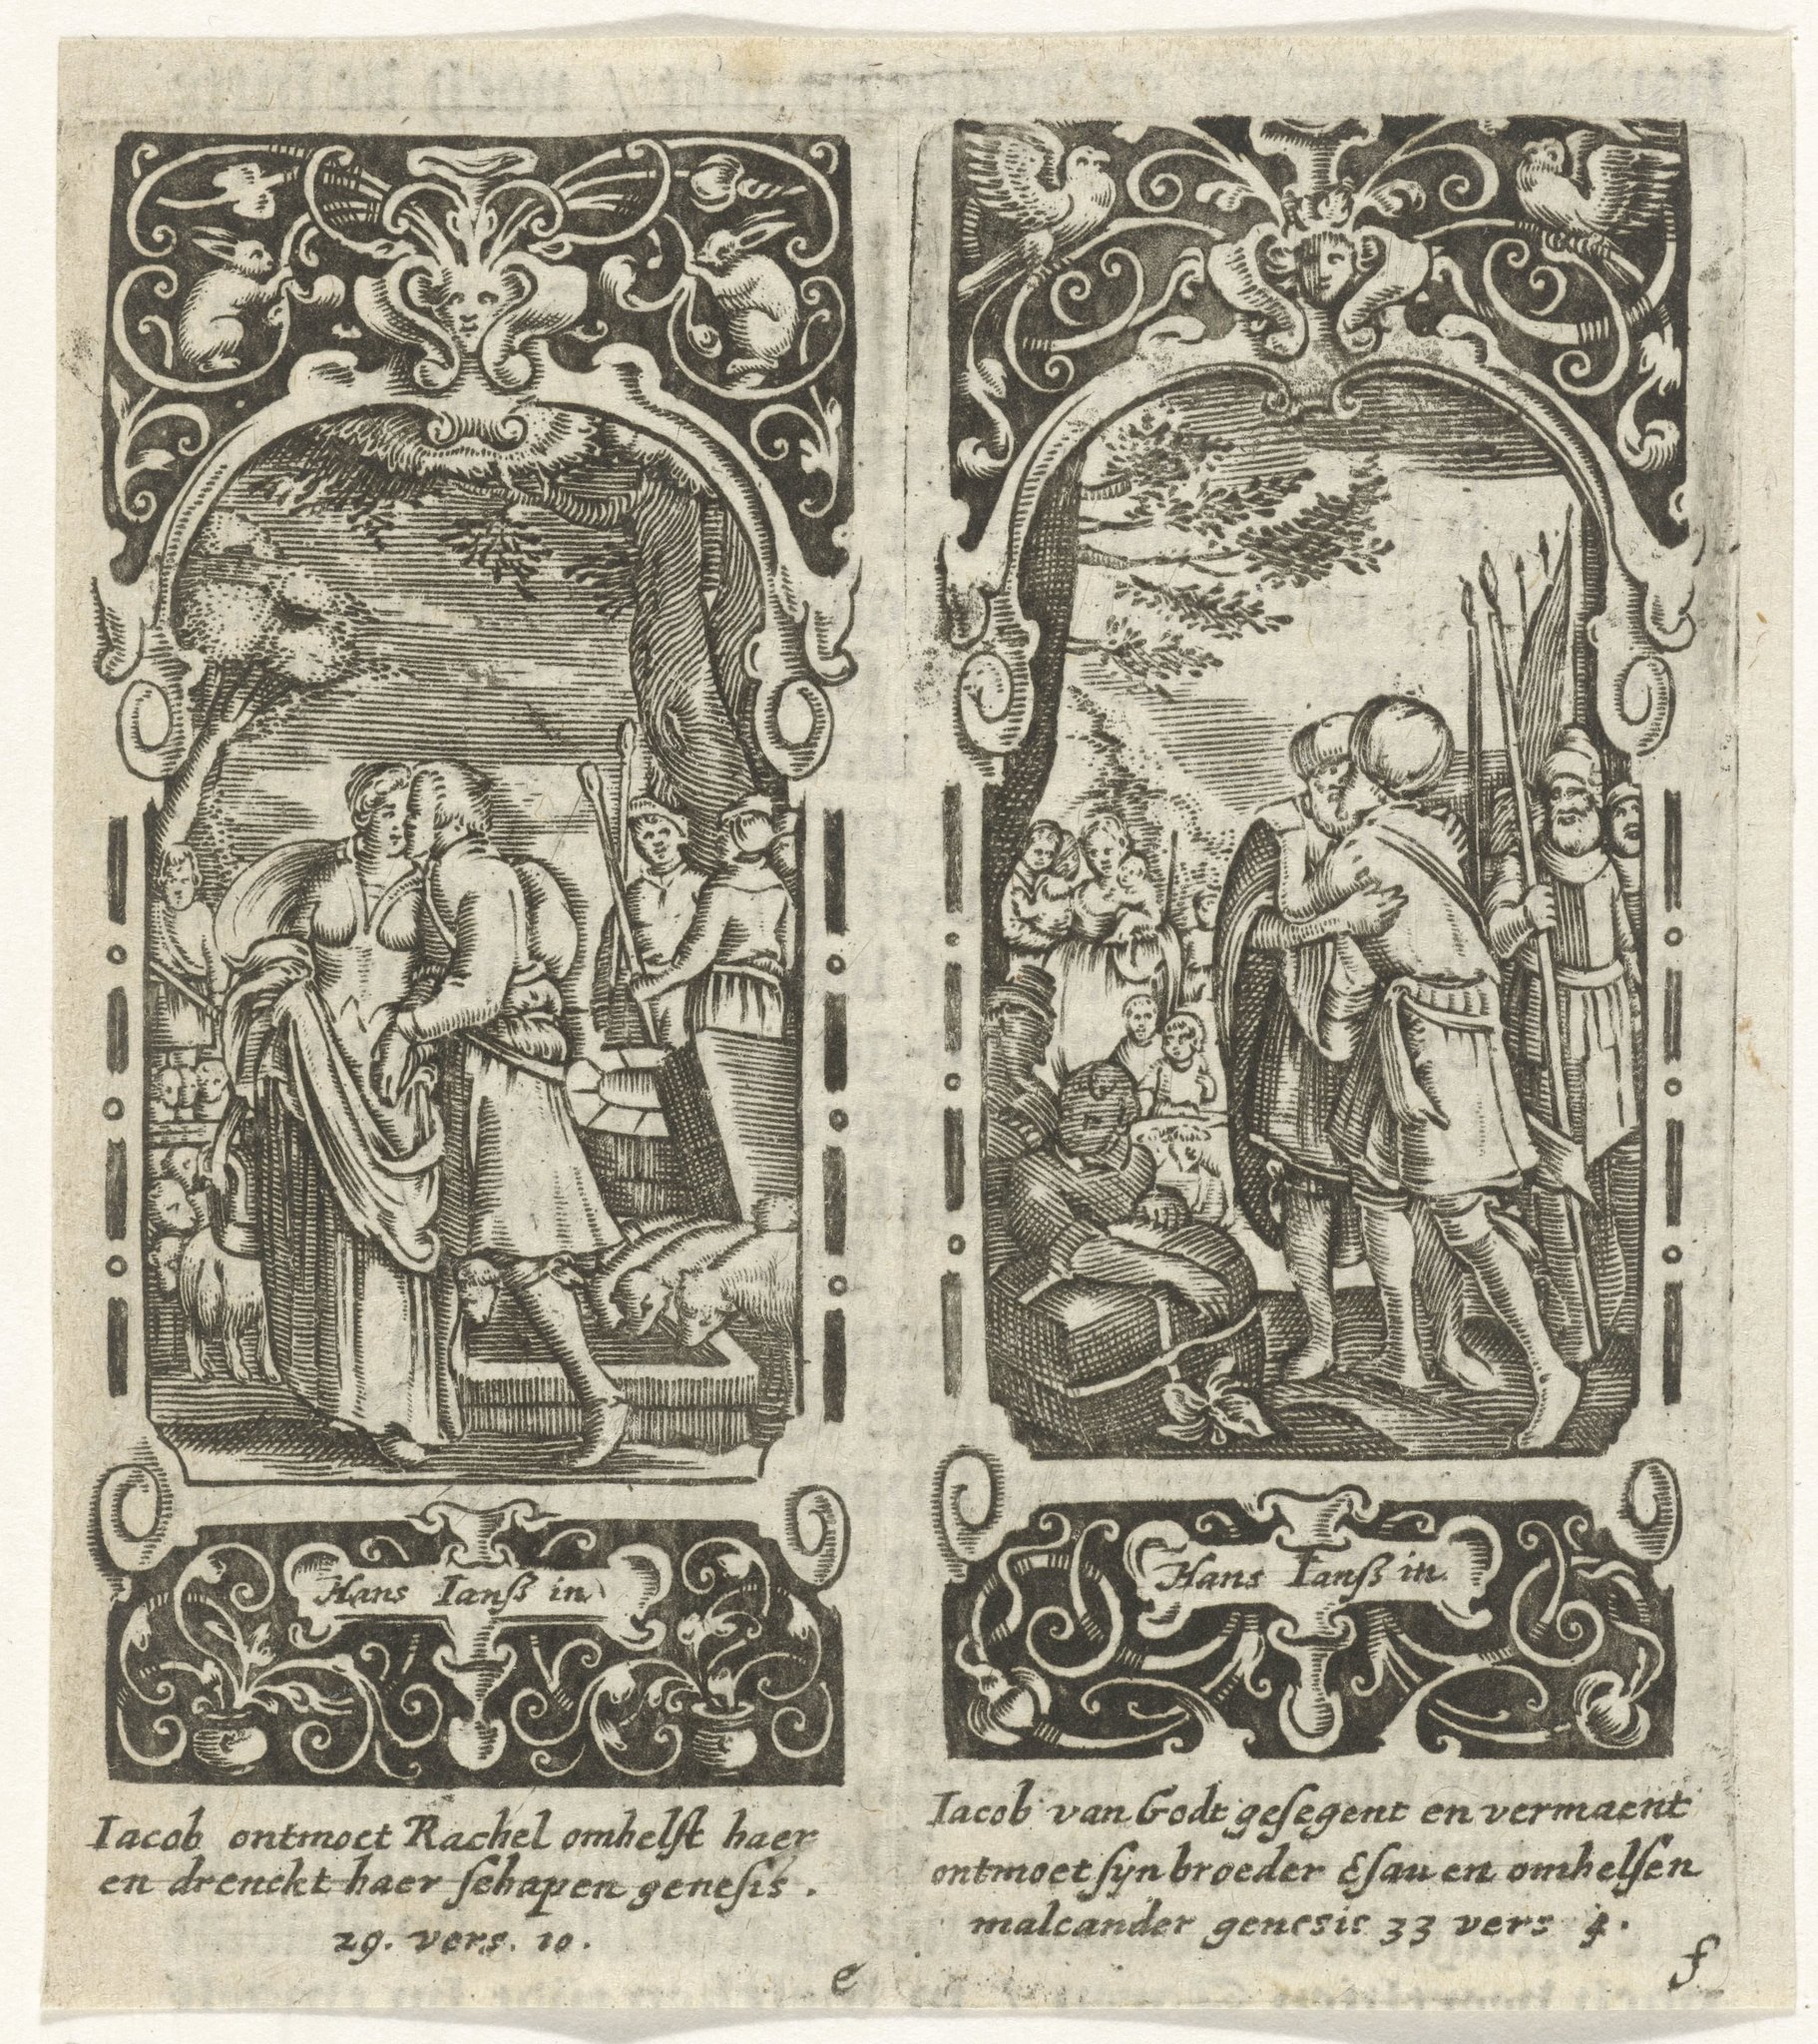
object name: book illustration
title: Scènes uit het leven van Jakob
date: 1615-1651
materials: paper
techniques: engraving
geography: amsterdam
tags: jacob kisses rachel and is moved to tears, jacob and esau are reconciled (genesis 33)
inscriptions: collector's mark: Lugt 2228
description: Twee afdrukken op één blad in ornamentele omlijsting. Links Jakob die Rachel kust en omhelst. De schapen van Rachel drinken uit een put (Gen. 29-10). Rechts Esau die Jakob omhelst. Op de achtergrond staan Lea en Rachel met hun kinderen en de soldaten van Esau (Gen. 33-4). In de marges onderschrift in het Nederlands. Vijfde en zesde prent (e en f) uit een serie van zes met scènes uit het leven van Jakob.